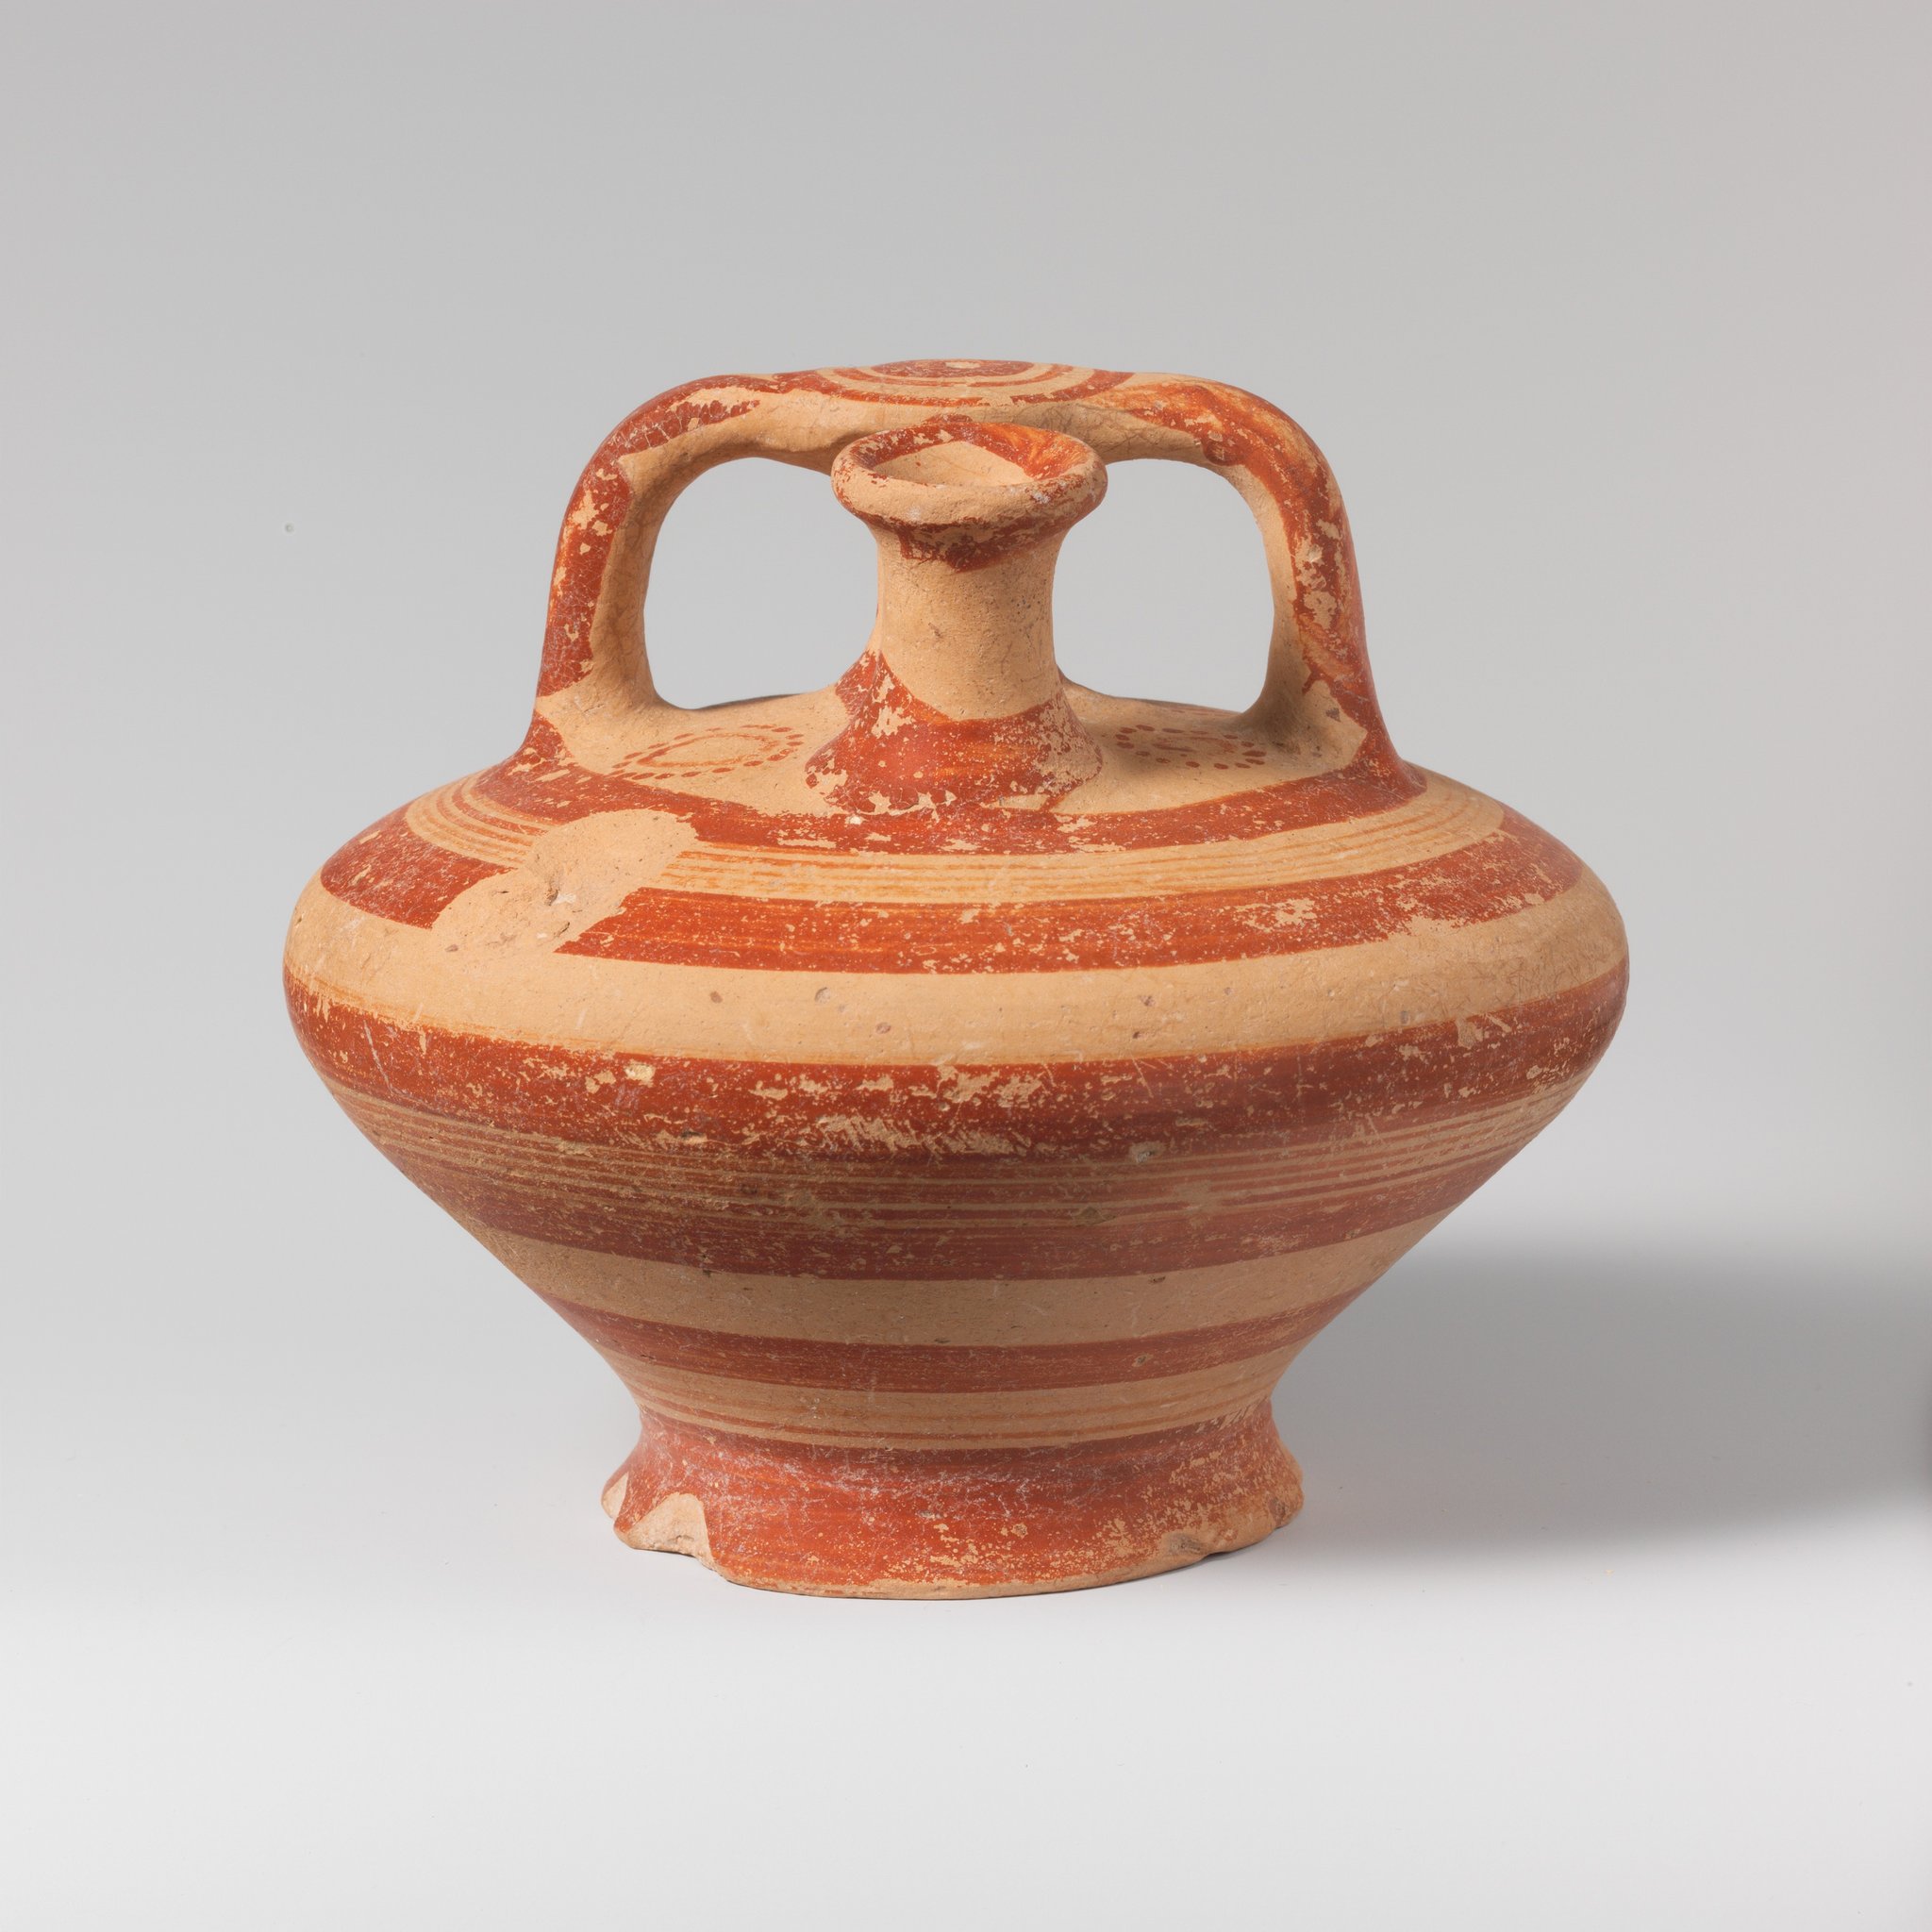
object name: stirrup jar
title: Terracotta stirrup jar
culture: mycenaean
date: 1300-1200 BCE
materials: terracotta